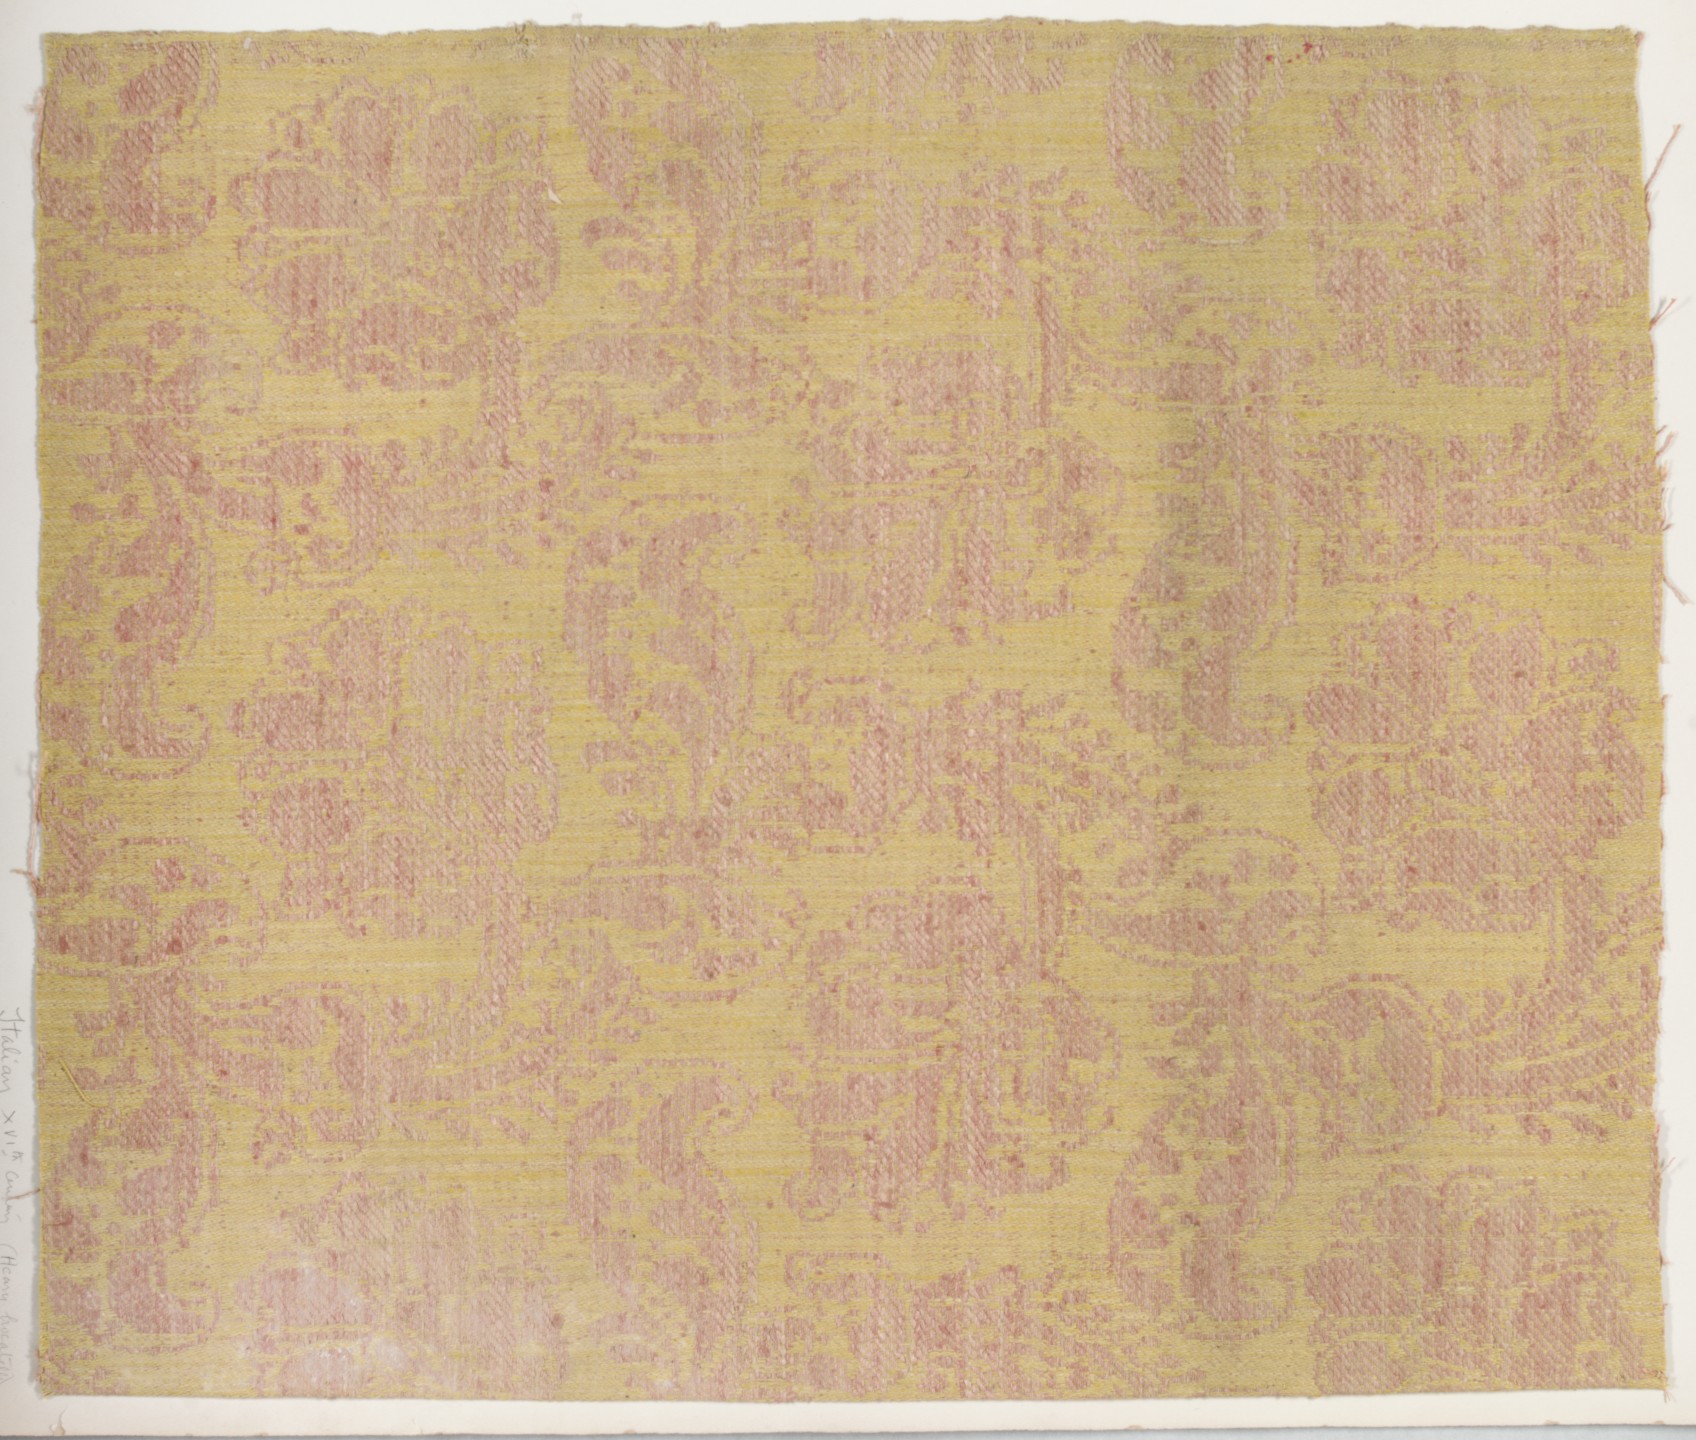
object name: fragment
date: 1501-1600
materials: silk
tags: flowers